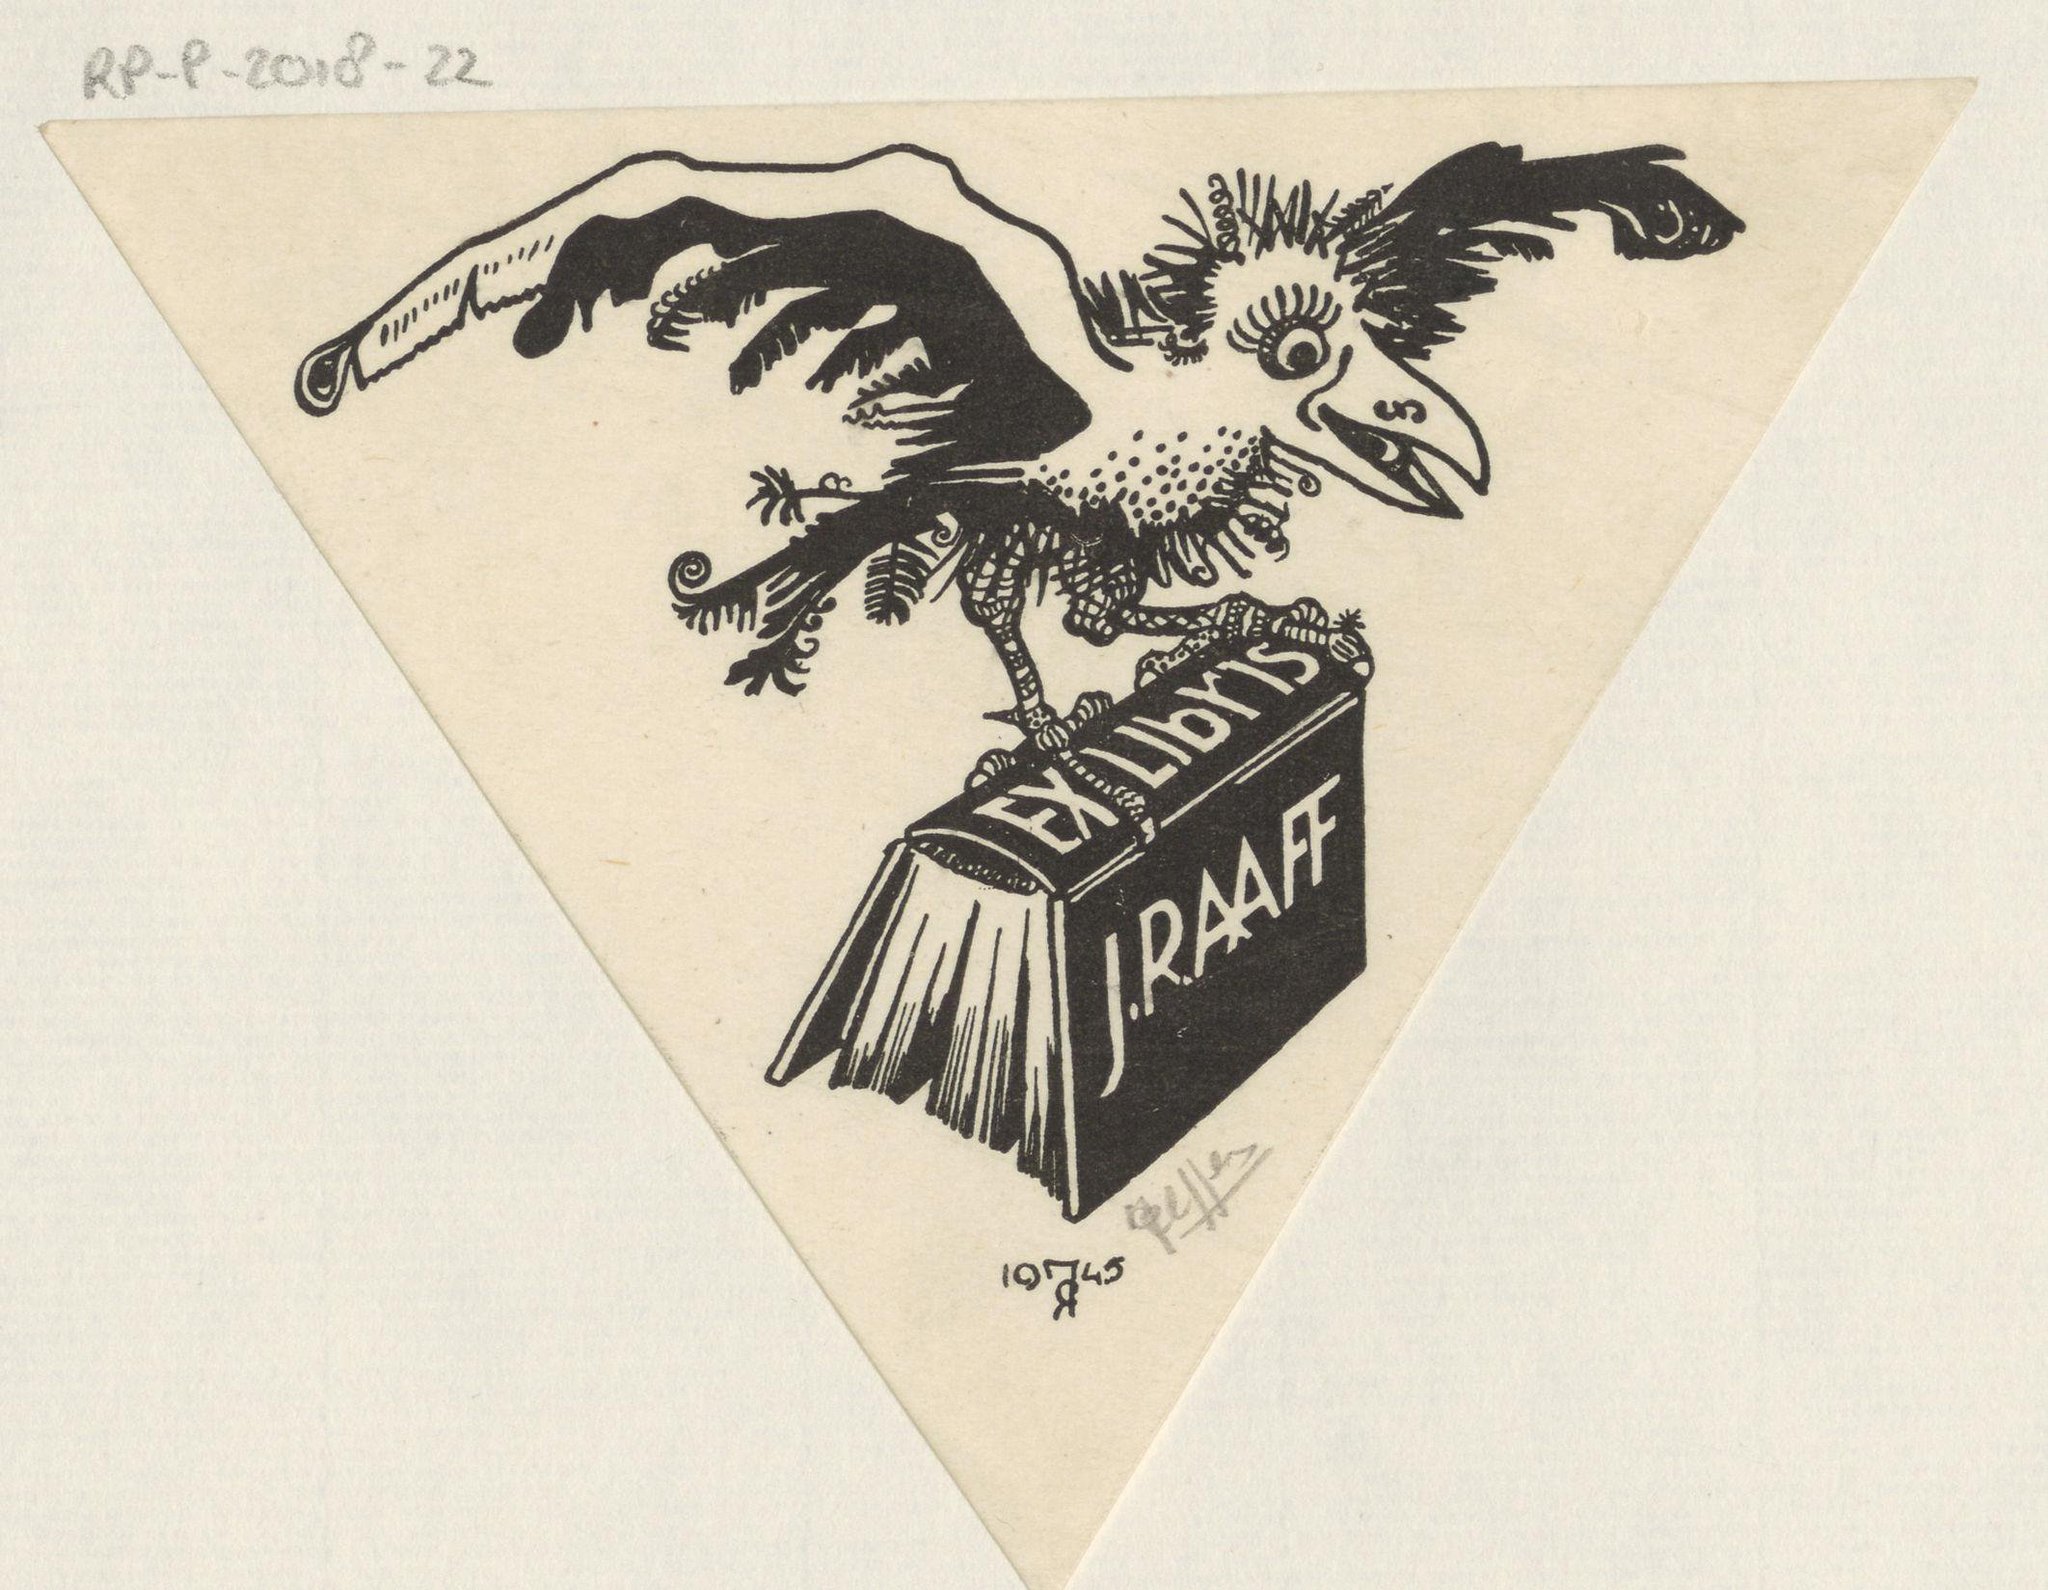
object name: bookplate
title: Ex libris van J. Raaff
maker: jan elffers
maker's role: print maker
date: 1945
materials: paper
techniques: lithograph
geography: netherlands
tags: song-birds: raven, book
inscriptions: signature: ‘JElffers’